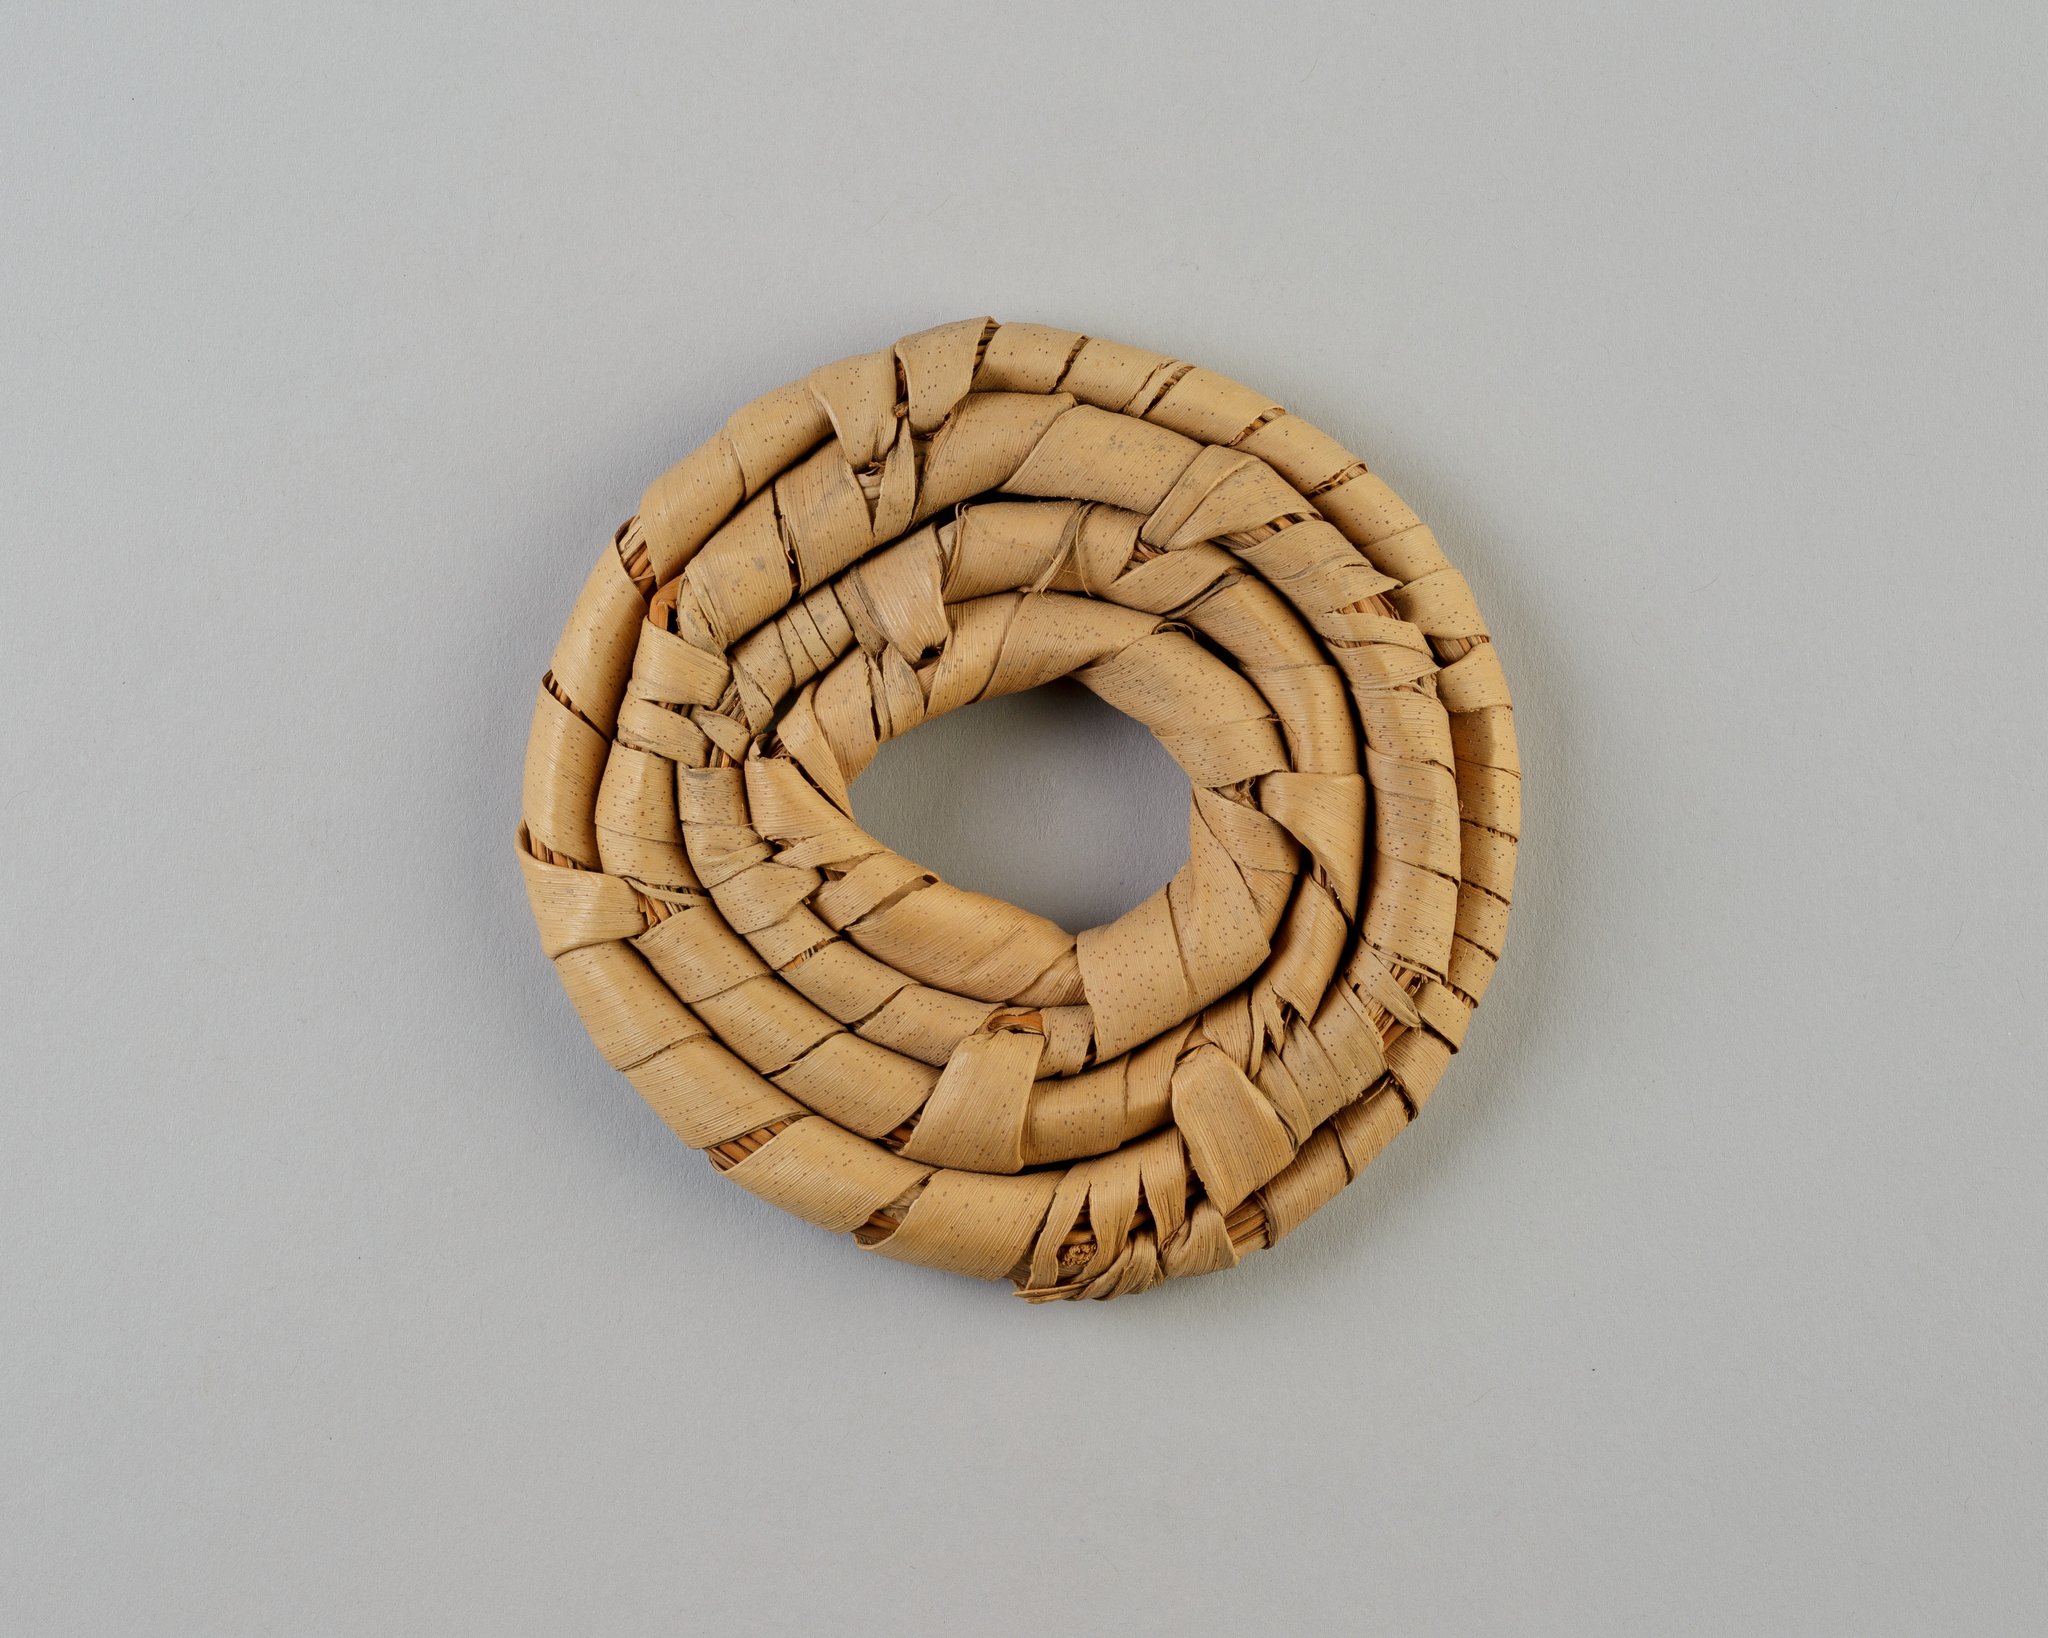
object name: basketry, model, senenmut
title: Pot Stand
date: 1479-1458 BCE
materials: leaf, fiber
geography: egypt